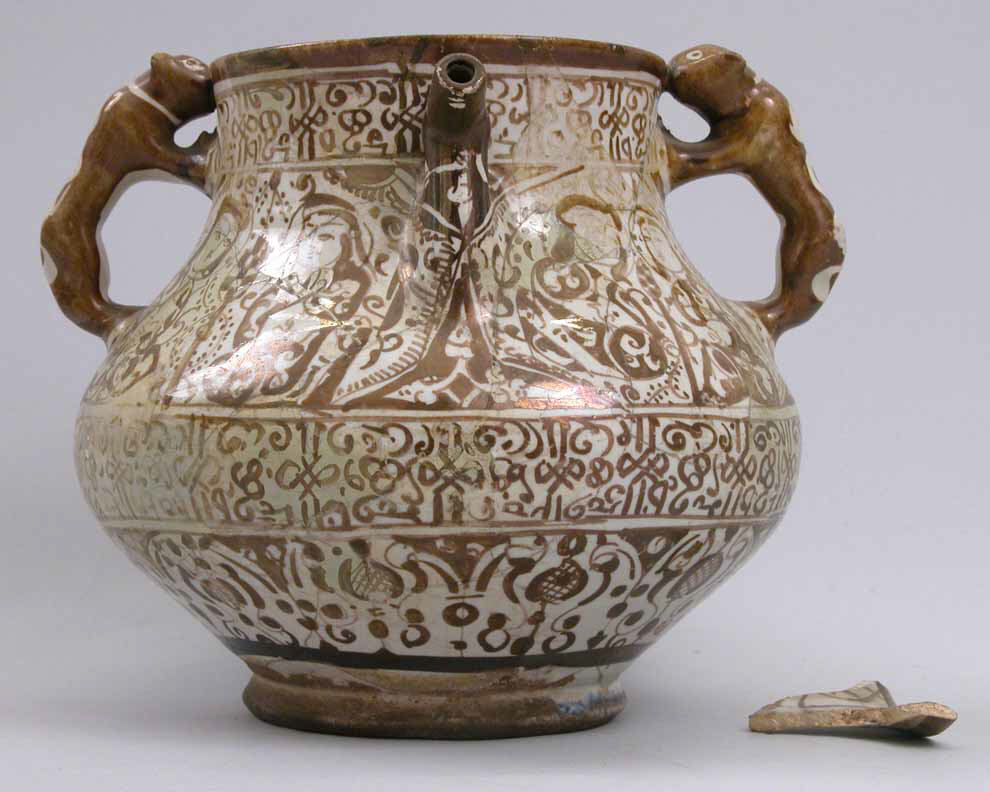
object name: ewer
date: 1167-1233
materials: stonepaste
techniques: glazing, luster painting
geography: iran